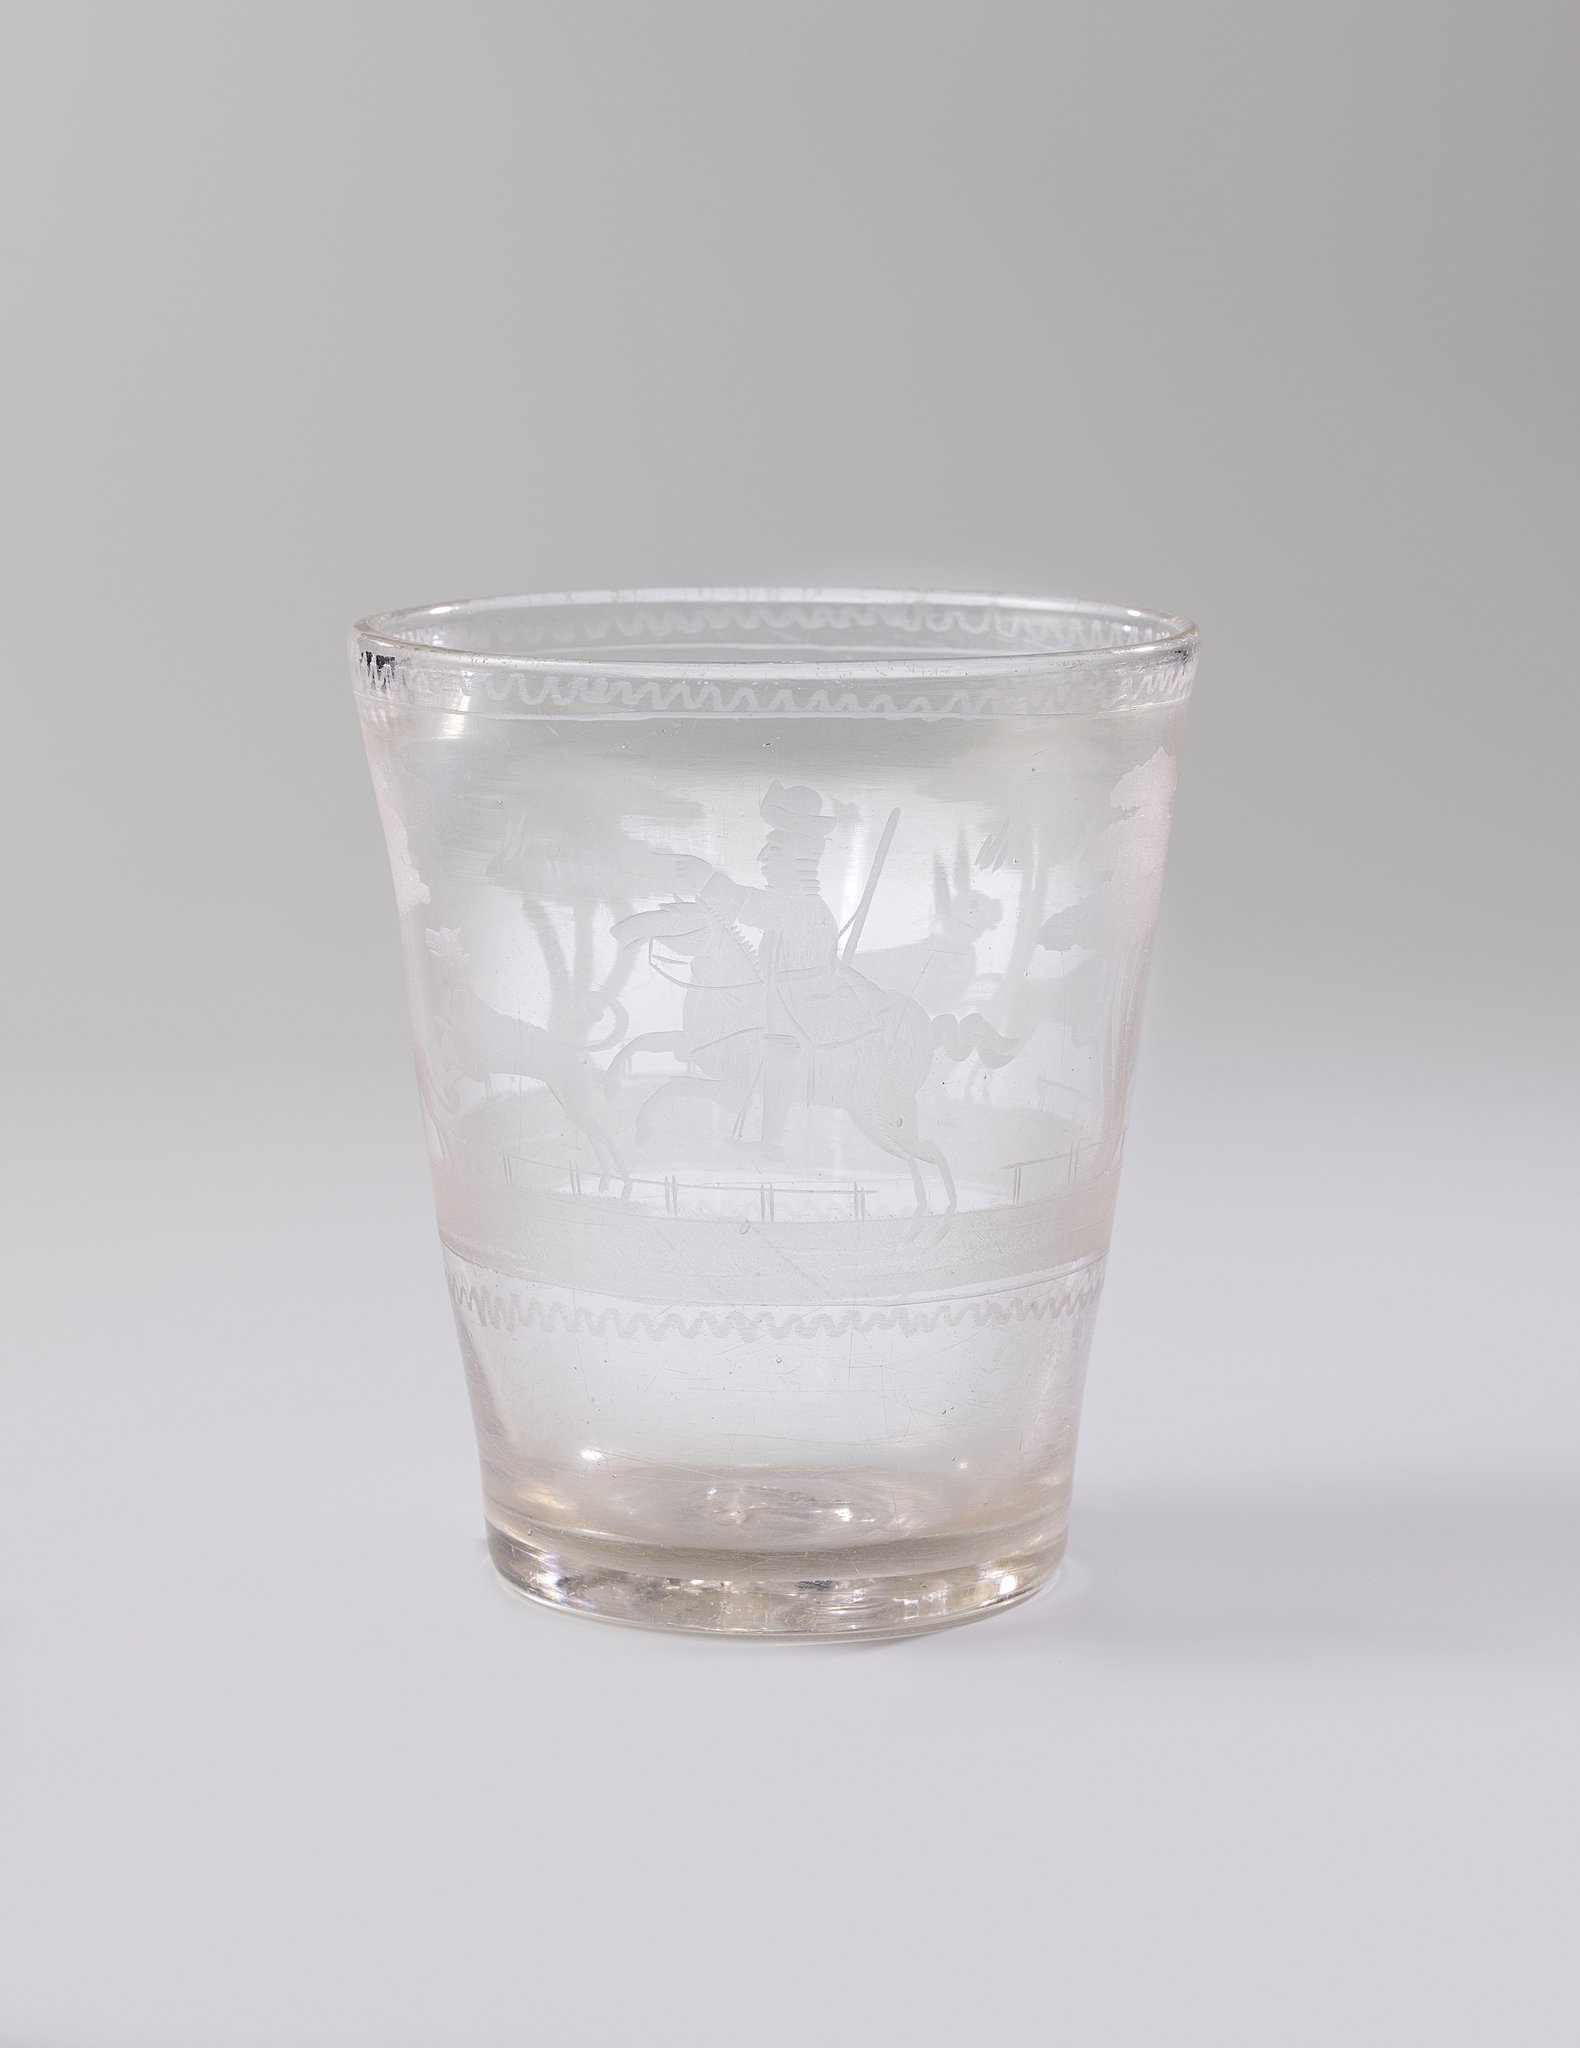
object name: cup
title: Beker met een jachtpartij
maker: Anonymous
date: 1725-1750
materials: glass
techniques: glassblowing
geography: bohemia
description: Beker van helder, kleurloos glas. Op de kelk een gegrageerde voorstelling van een jager te paard met twee jachthonden en enkele konijnen.